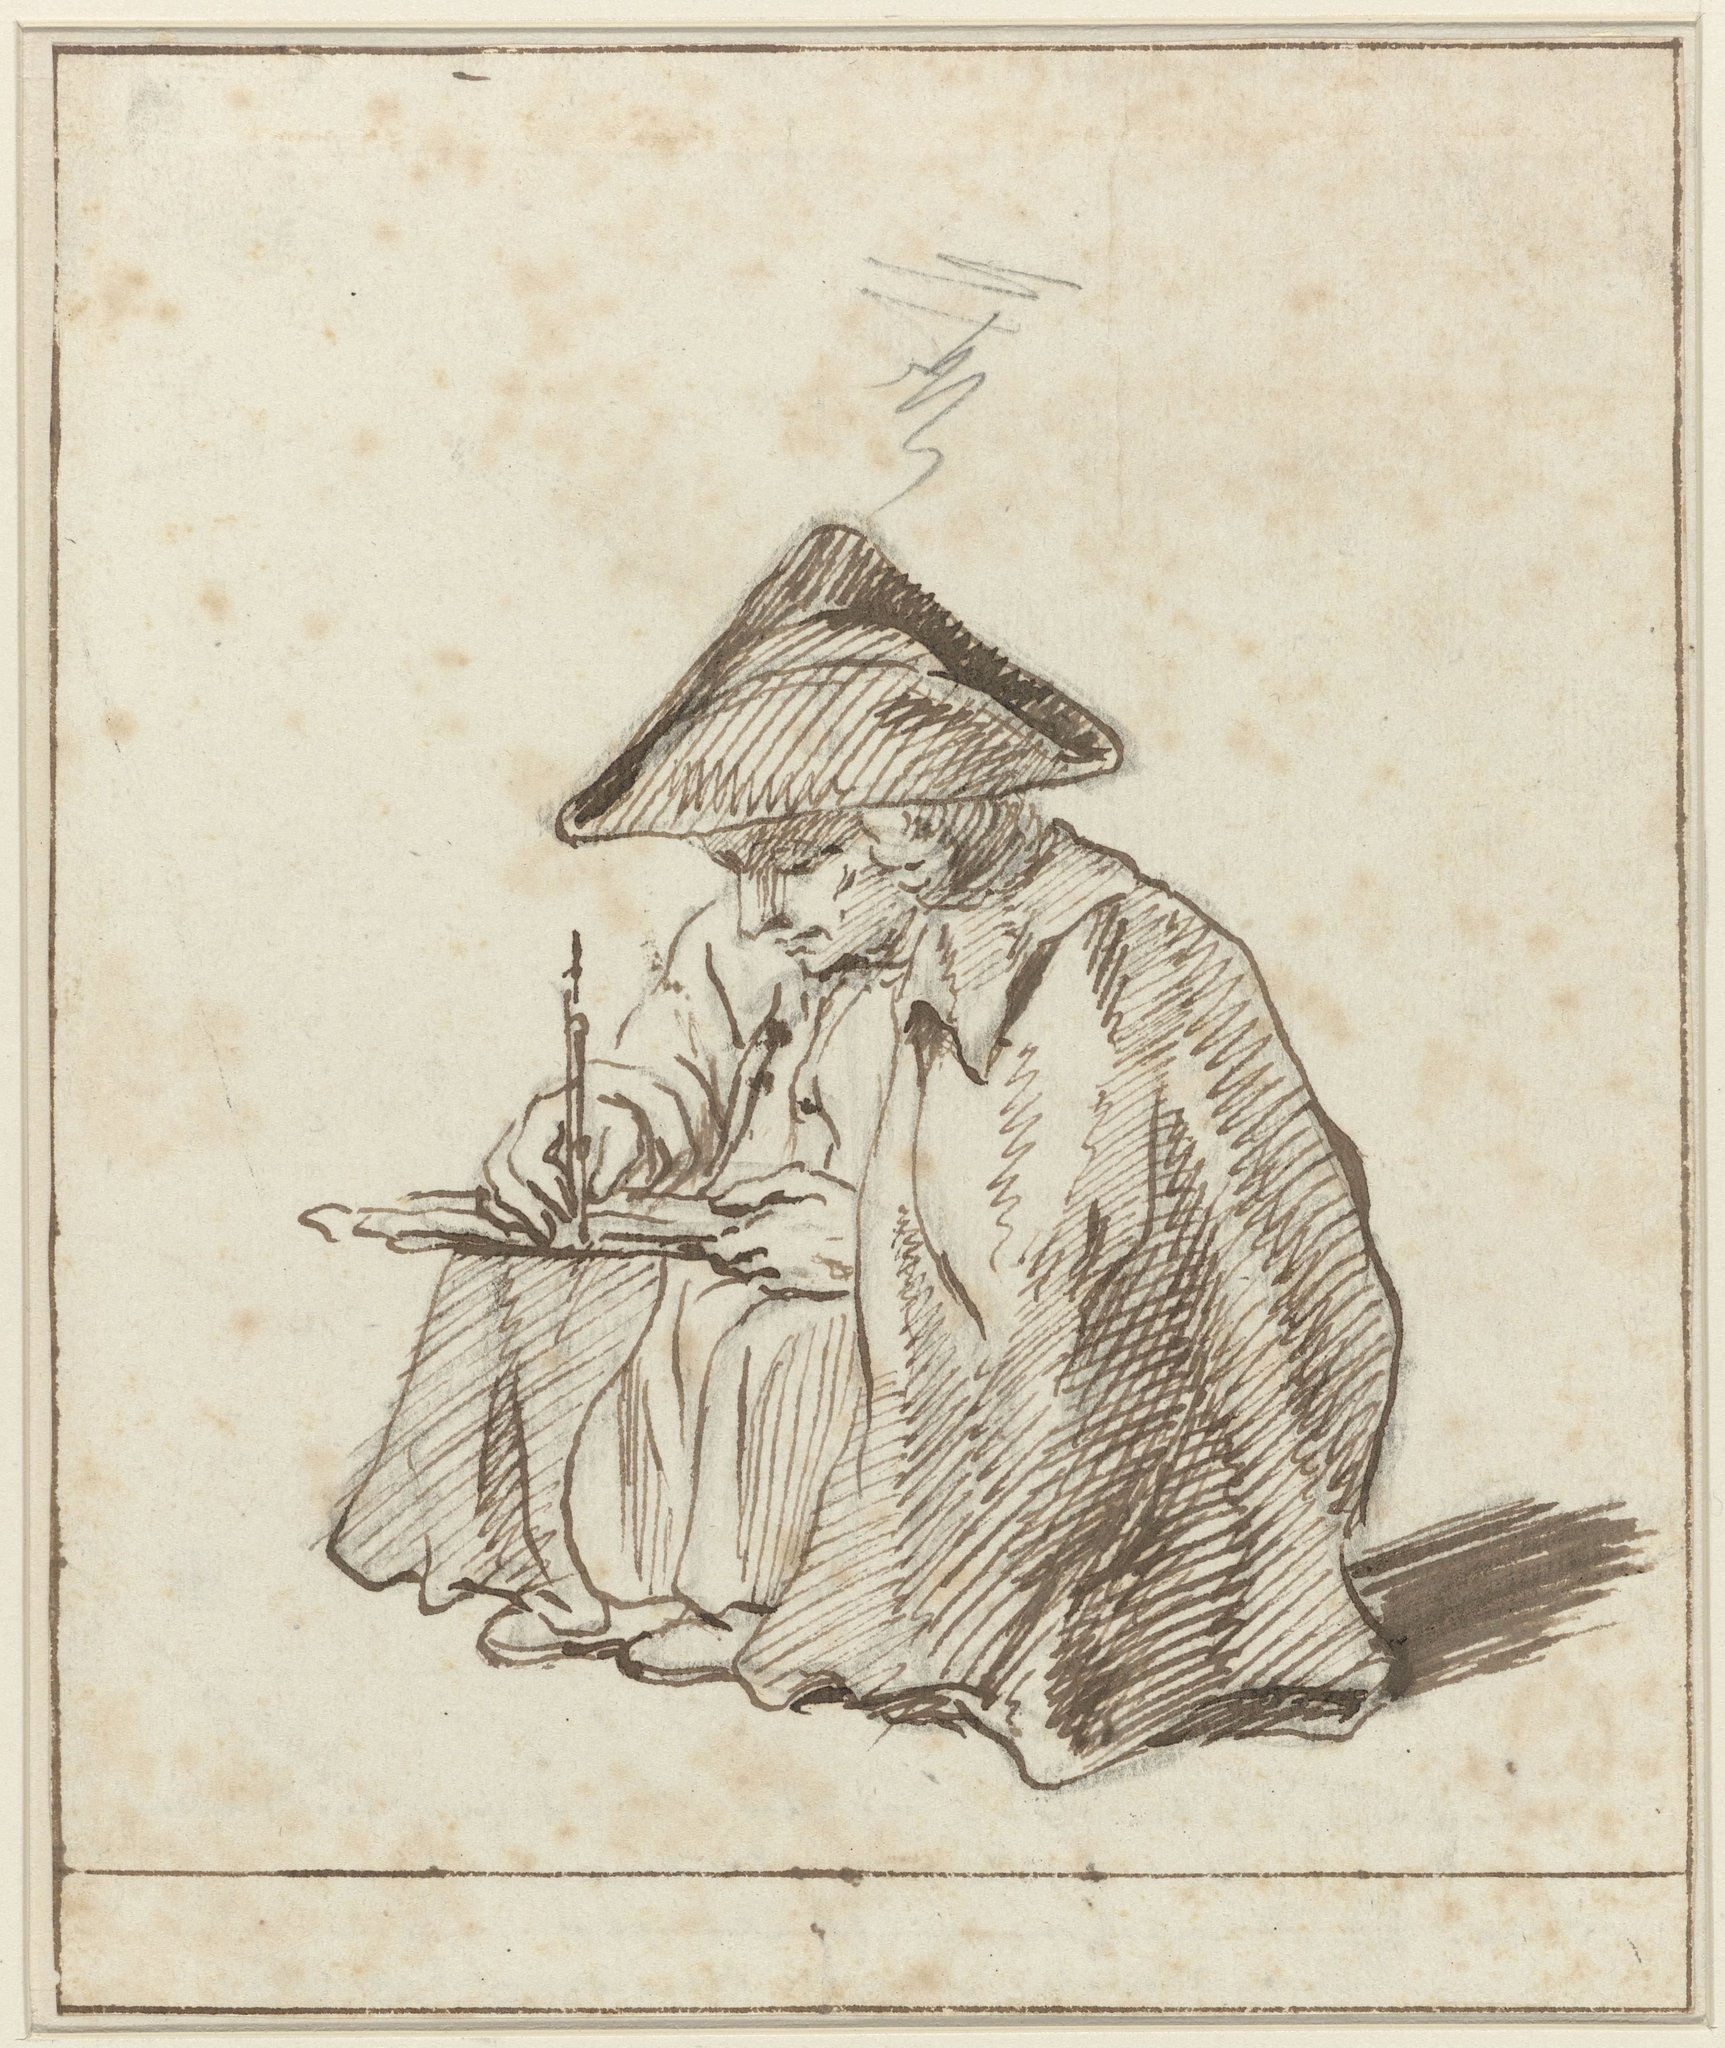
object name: drawing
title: Portret van Joseph Marinkelle, zittend tekenend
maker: reinier vinkeles (i)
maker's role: draughtsman, print maker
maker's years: 1741-1816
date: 1768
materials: chalk, ink, paper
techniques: pen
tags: rotterdam, amsterdam, joseph marinkel, historical persons, portrait, self-portrait of artist